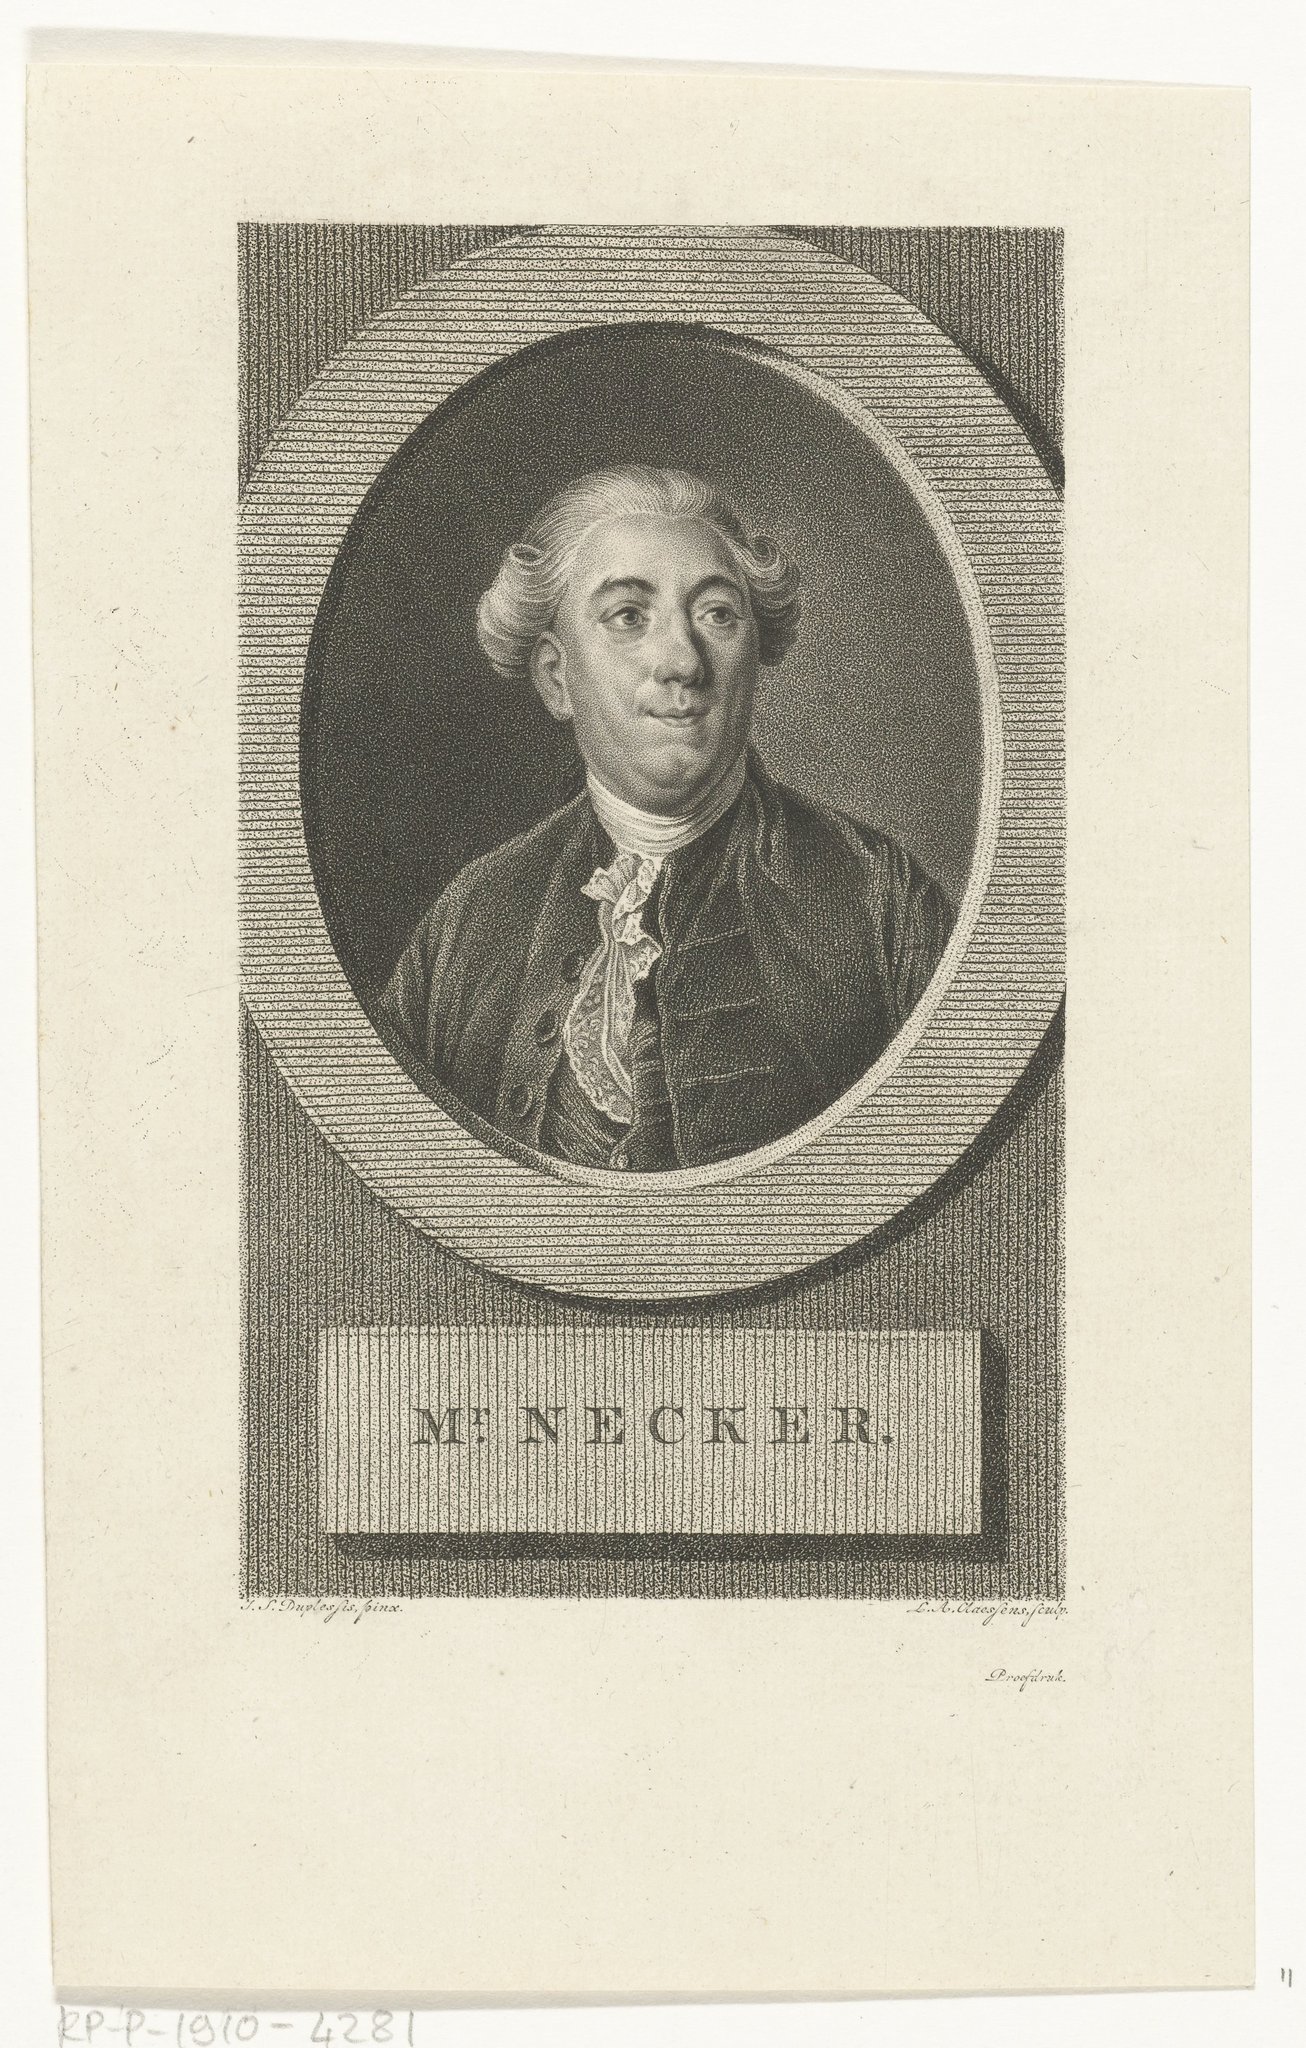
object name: print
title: Portret van Jacques Necker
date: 1792-1808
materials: paper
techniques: engraving, etching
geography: amsterdam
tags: genève, coppet, staatsman, jacques necker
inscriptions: collector's mark: Lugt 2228